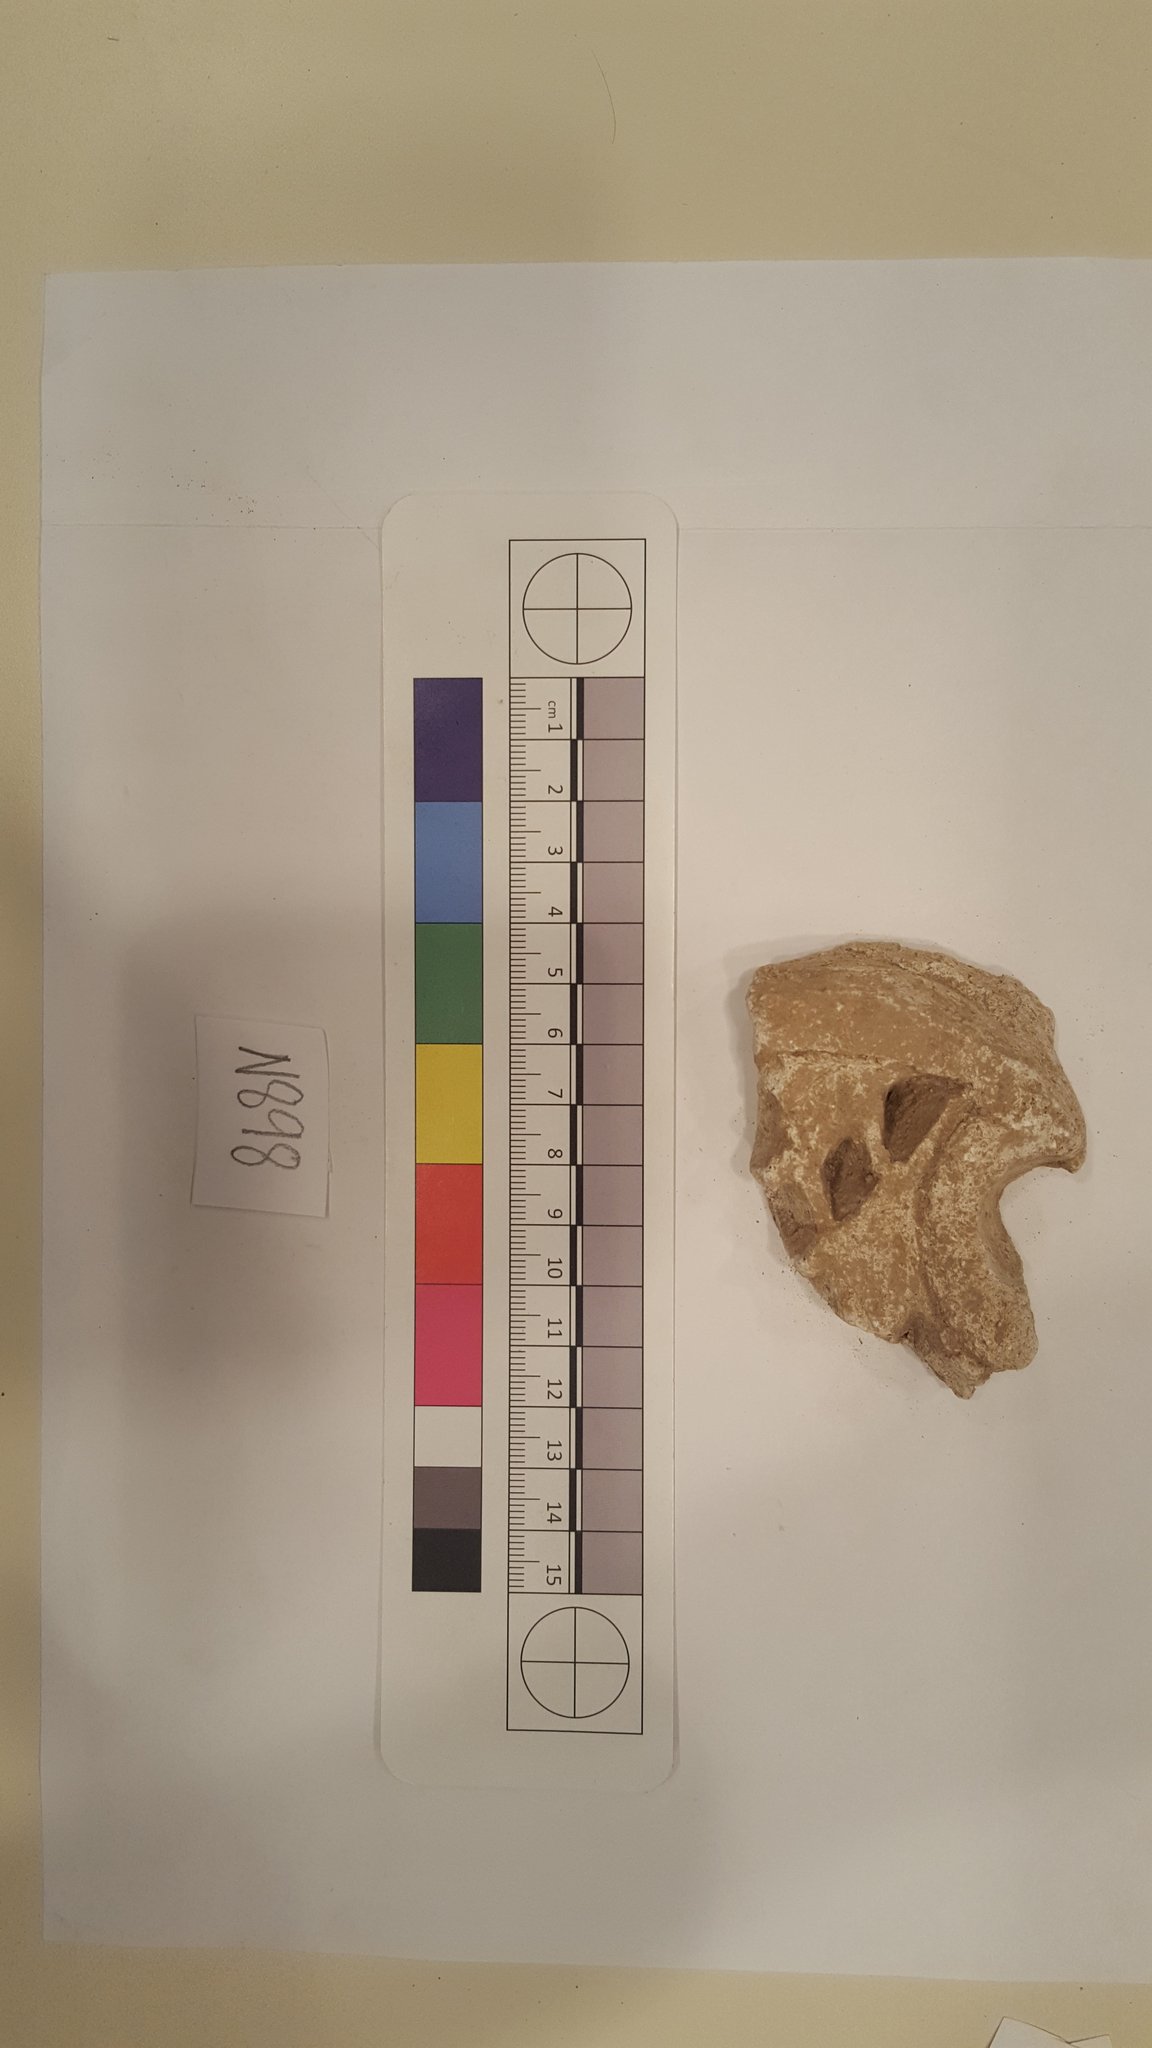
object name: fragment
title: Stucco Fragment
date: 701-1200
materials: plaster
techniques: carving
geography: iran